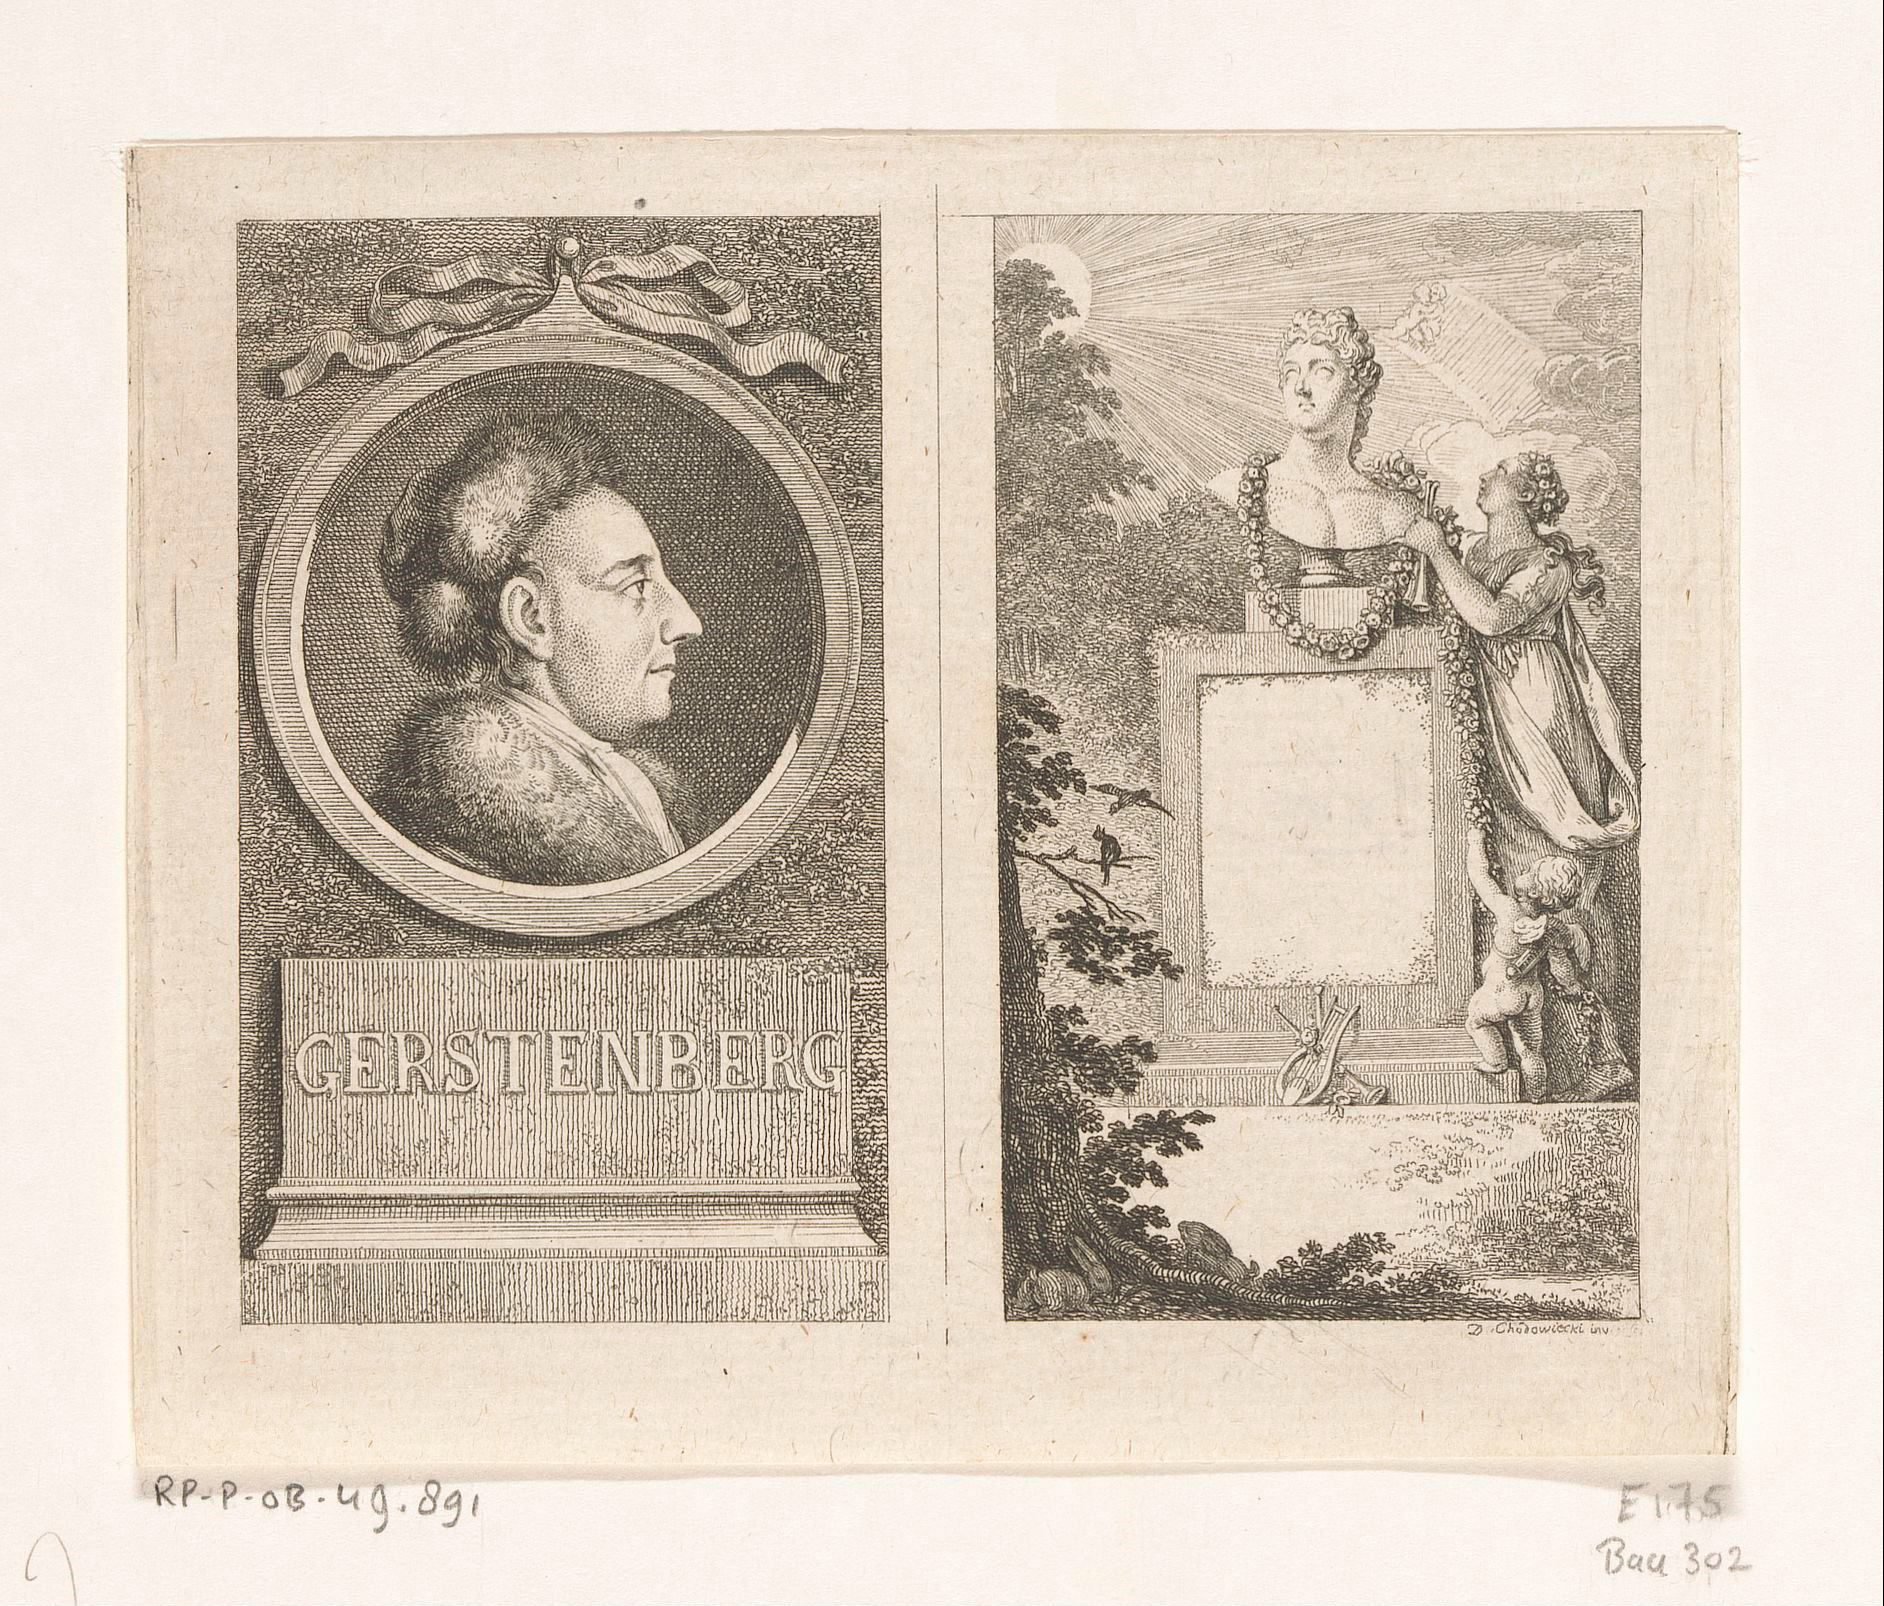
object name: print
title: Portret van Heinrich Wilhelm von Gerstenberg en een buste van Apollo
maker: daniel nikolaus chodowiecki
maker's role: draughtsman, print maker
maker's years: 1726-1801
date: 1776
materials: paper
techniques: etching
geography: berlin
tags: (story of) apollo (phoebus), historical persons, portrait of a writer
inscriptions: collector's mark: Lugt 2228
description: Een latere staat van deze prent is gebruikt in: Voss, Johann Heinrich. Musen Almanach für 1777 in Hamburg. Hamburg: L.E. Bohn.